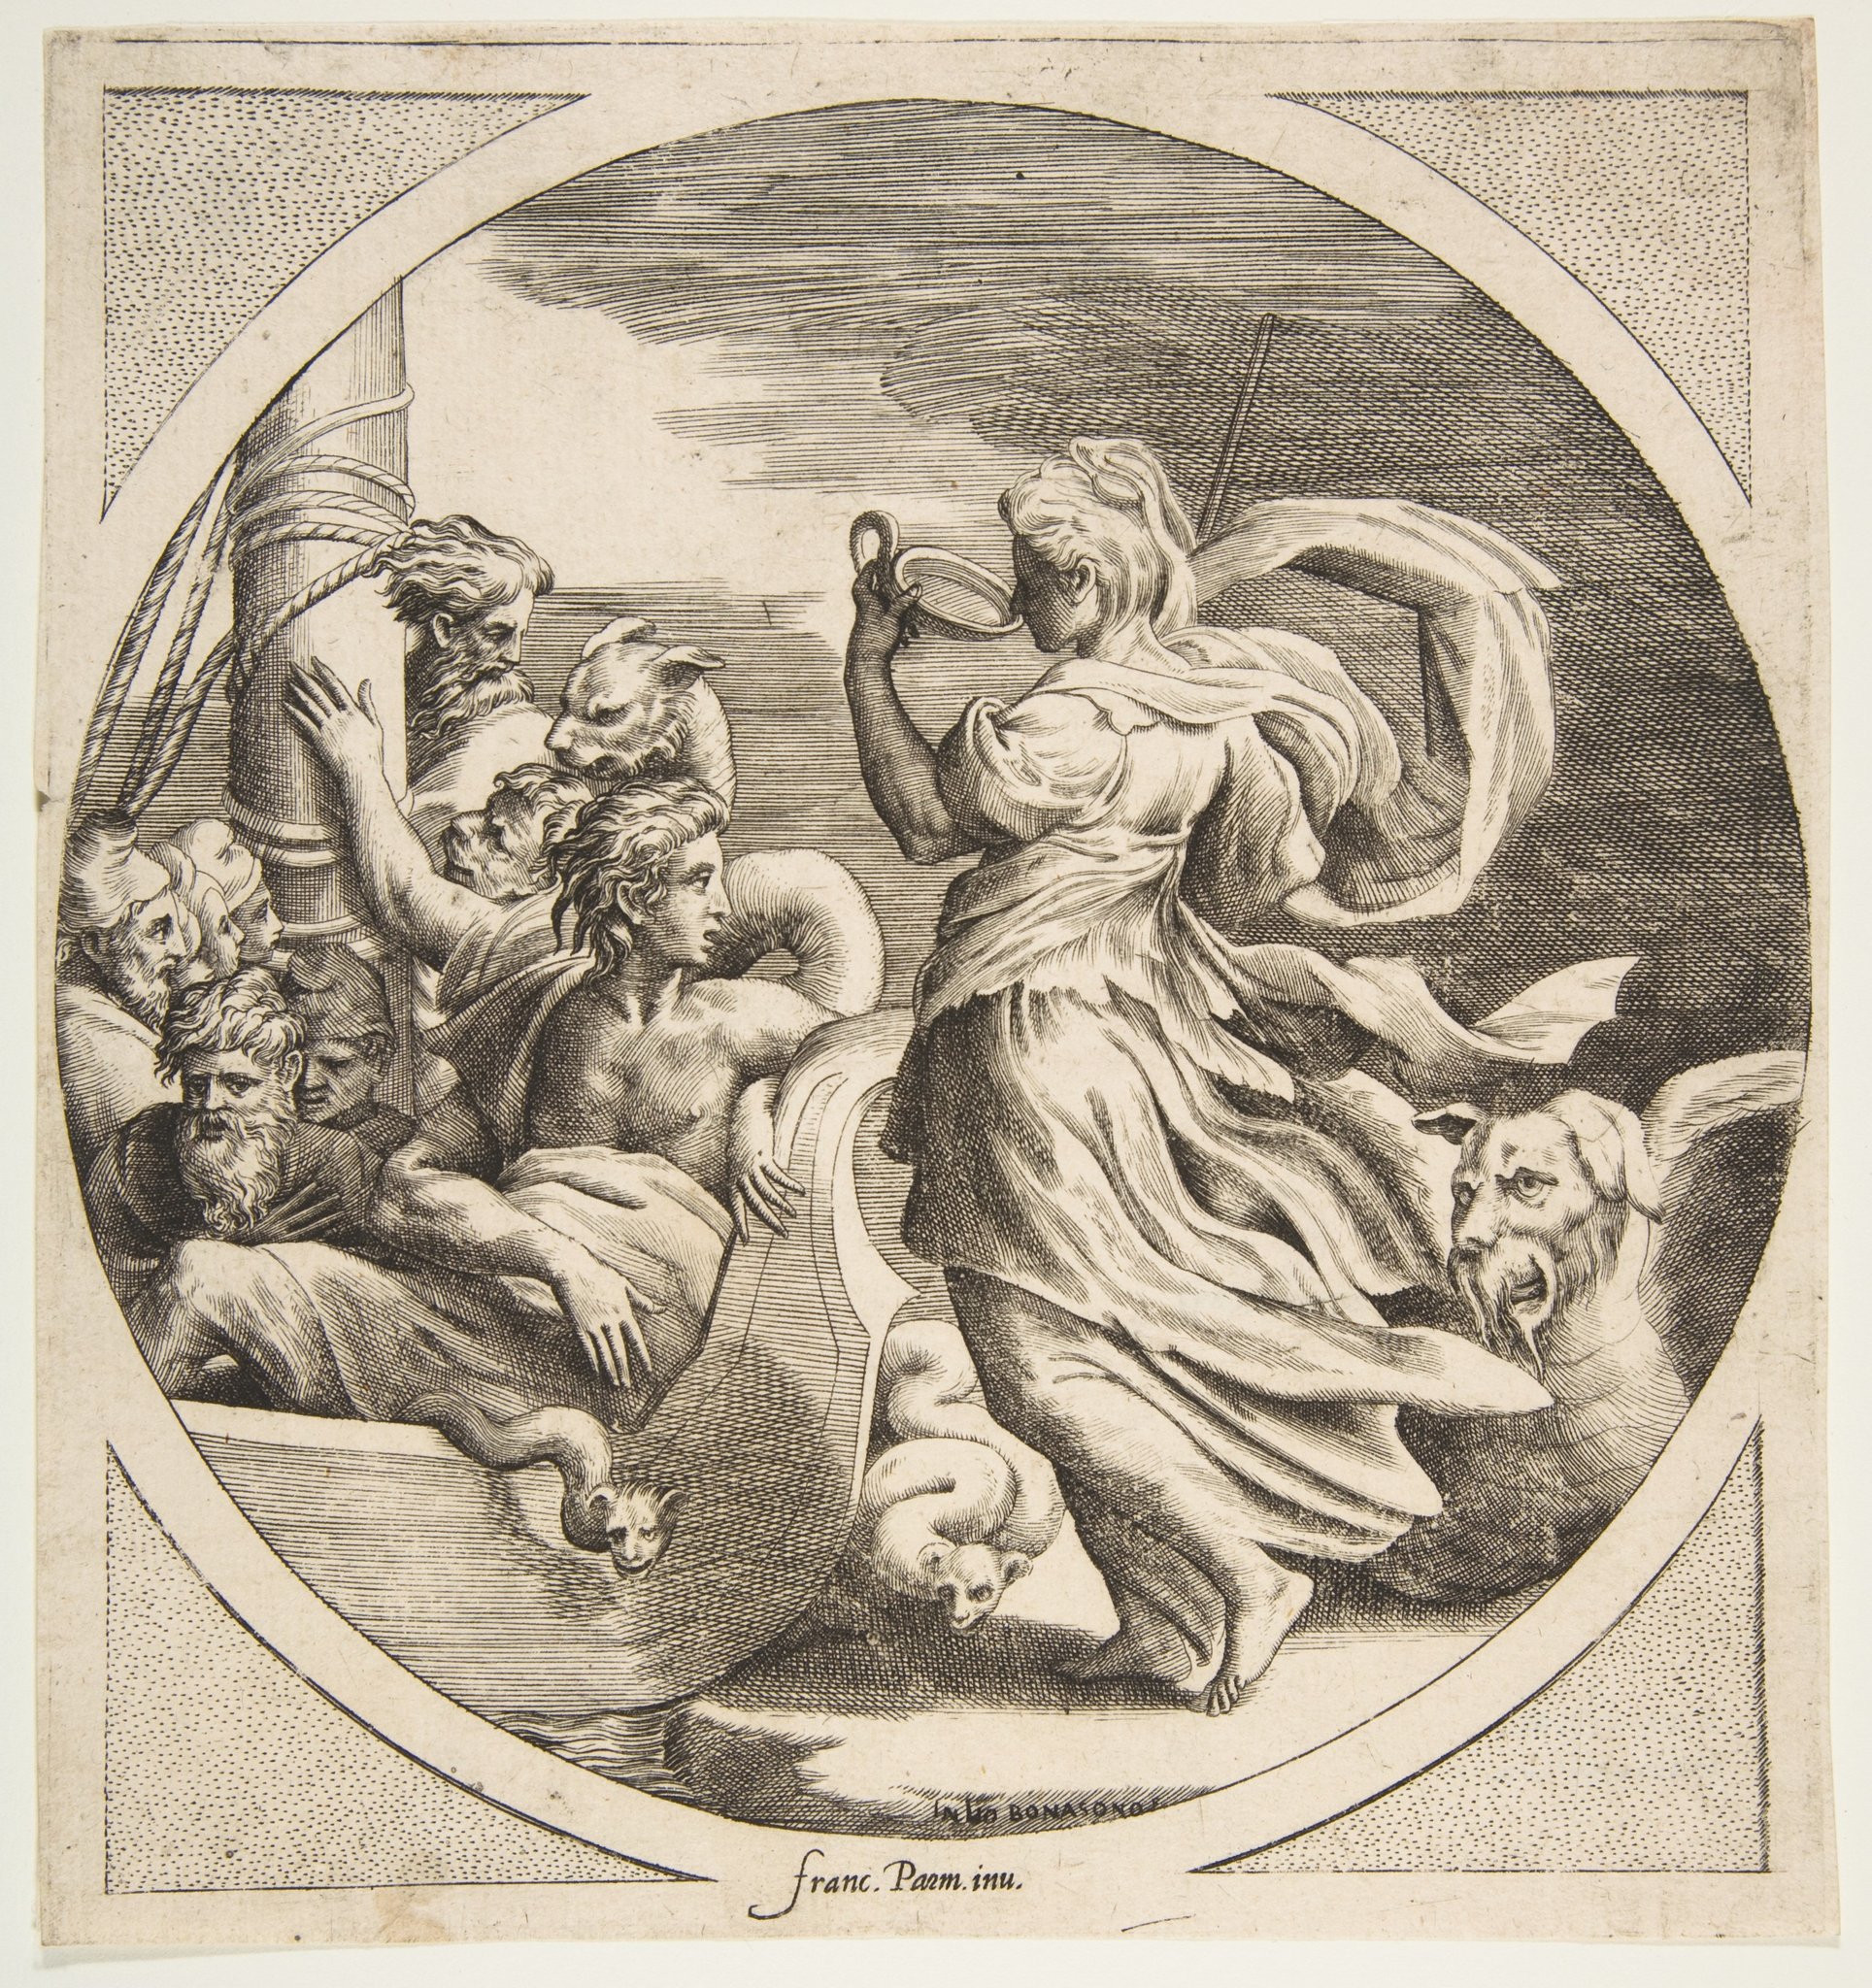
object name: print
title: Circe drinking from a cup with the companions of Ulysses in a boat at left, a circular composition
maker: giulio bonasone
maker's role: artist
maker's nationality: italian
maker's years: 1510-1576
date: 1531-1576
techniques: engraving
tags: men,women,boats,cups